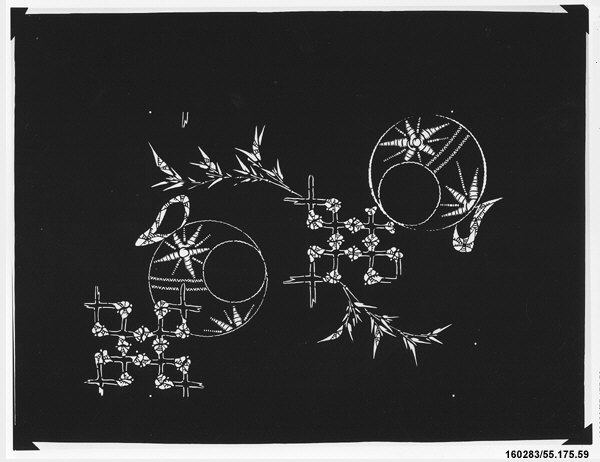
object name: stencil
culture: japanese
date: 1801-1900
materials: paper